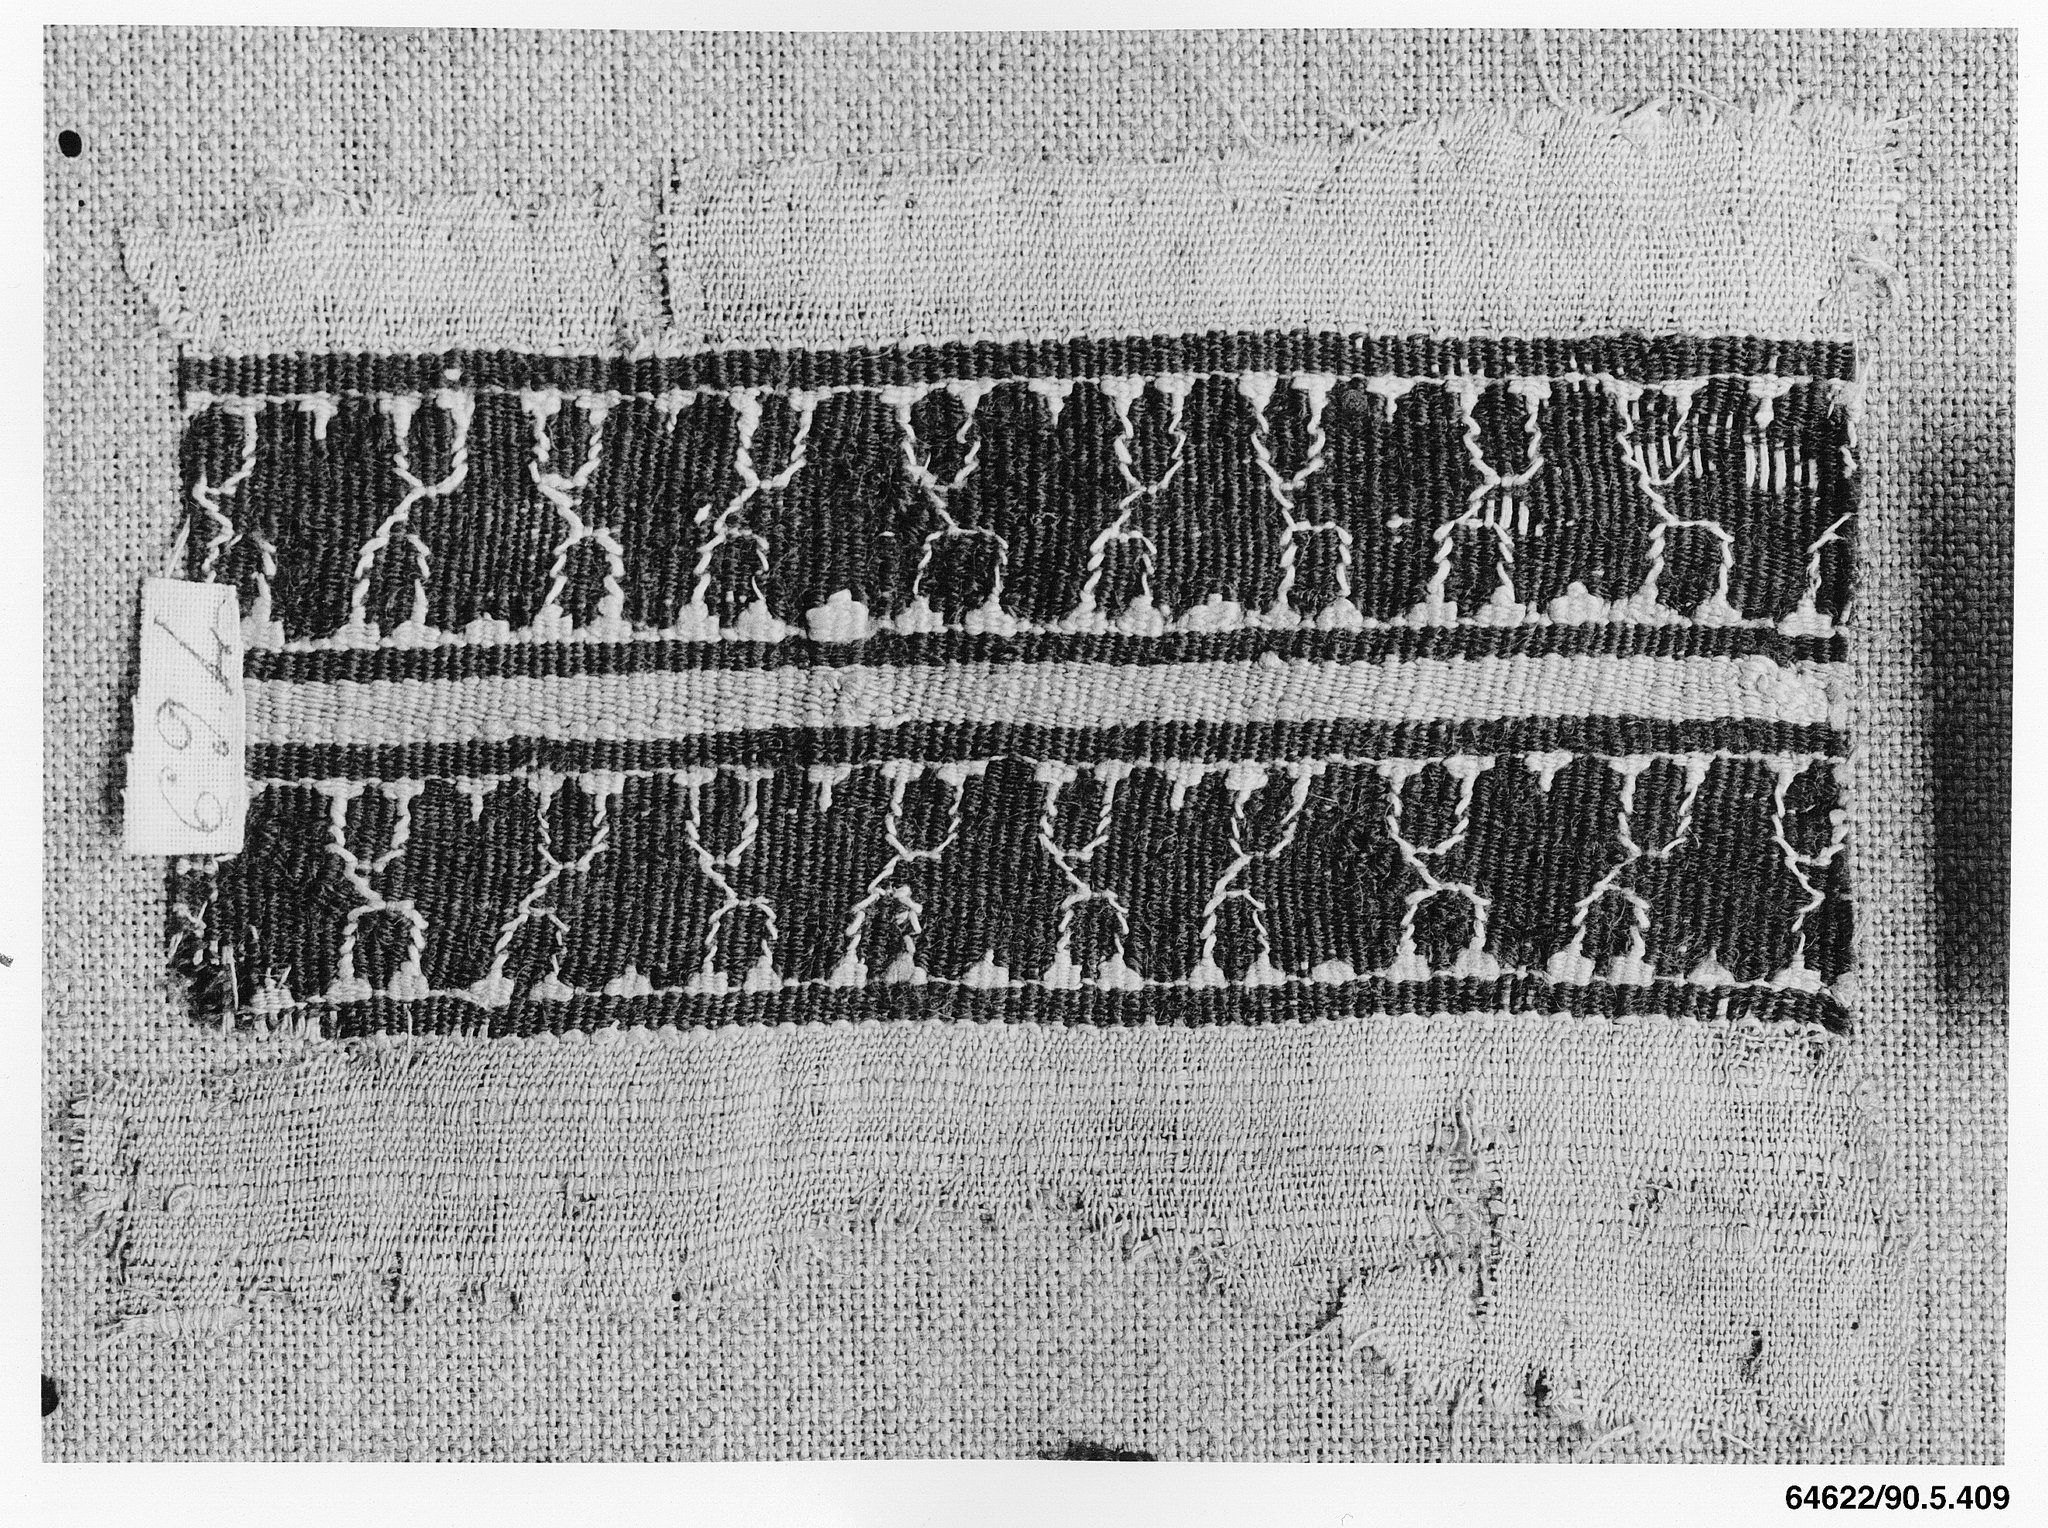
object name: textile fragment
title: Fragment of a Sleeve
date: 201-400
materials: linen, wool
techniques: weave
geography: egypt